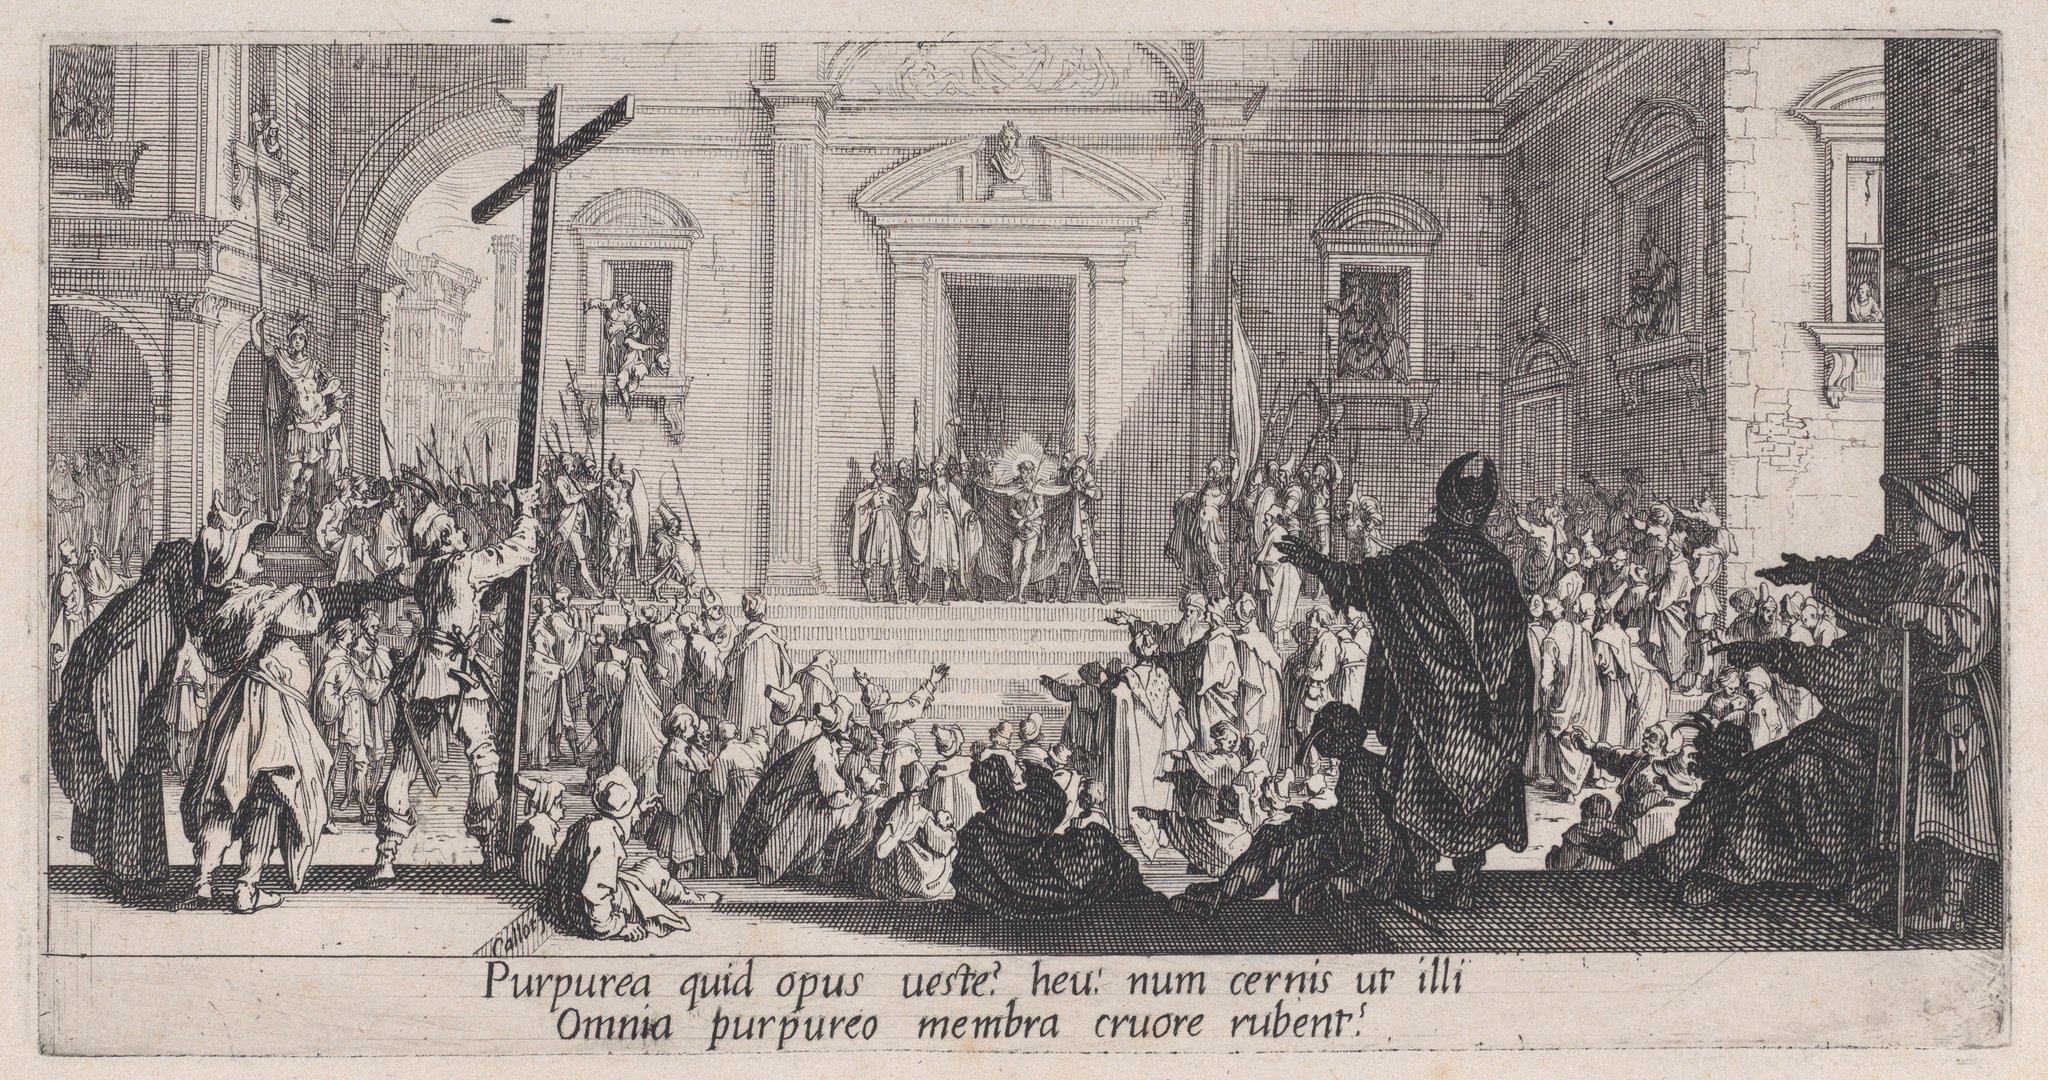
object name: print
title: La Présentation au Peuple (The Presentation of Christ to the People), from "La Grande Passion" (The Large Passion)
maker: jacques callot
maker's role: artist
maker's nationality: french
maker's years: 1592-1635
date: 1619-1624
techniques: engraving, etching